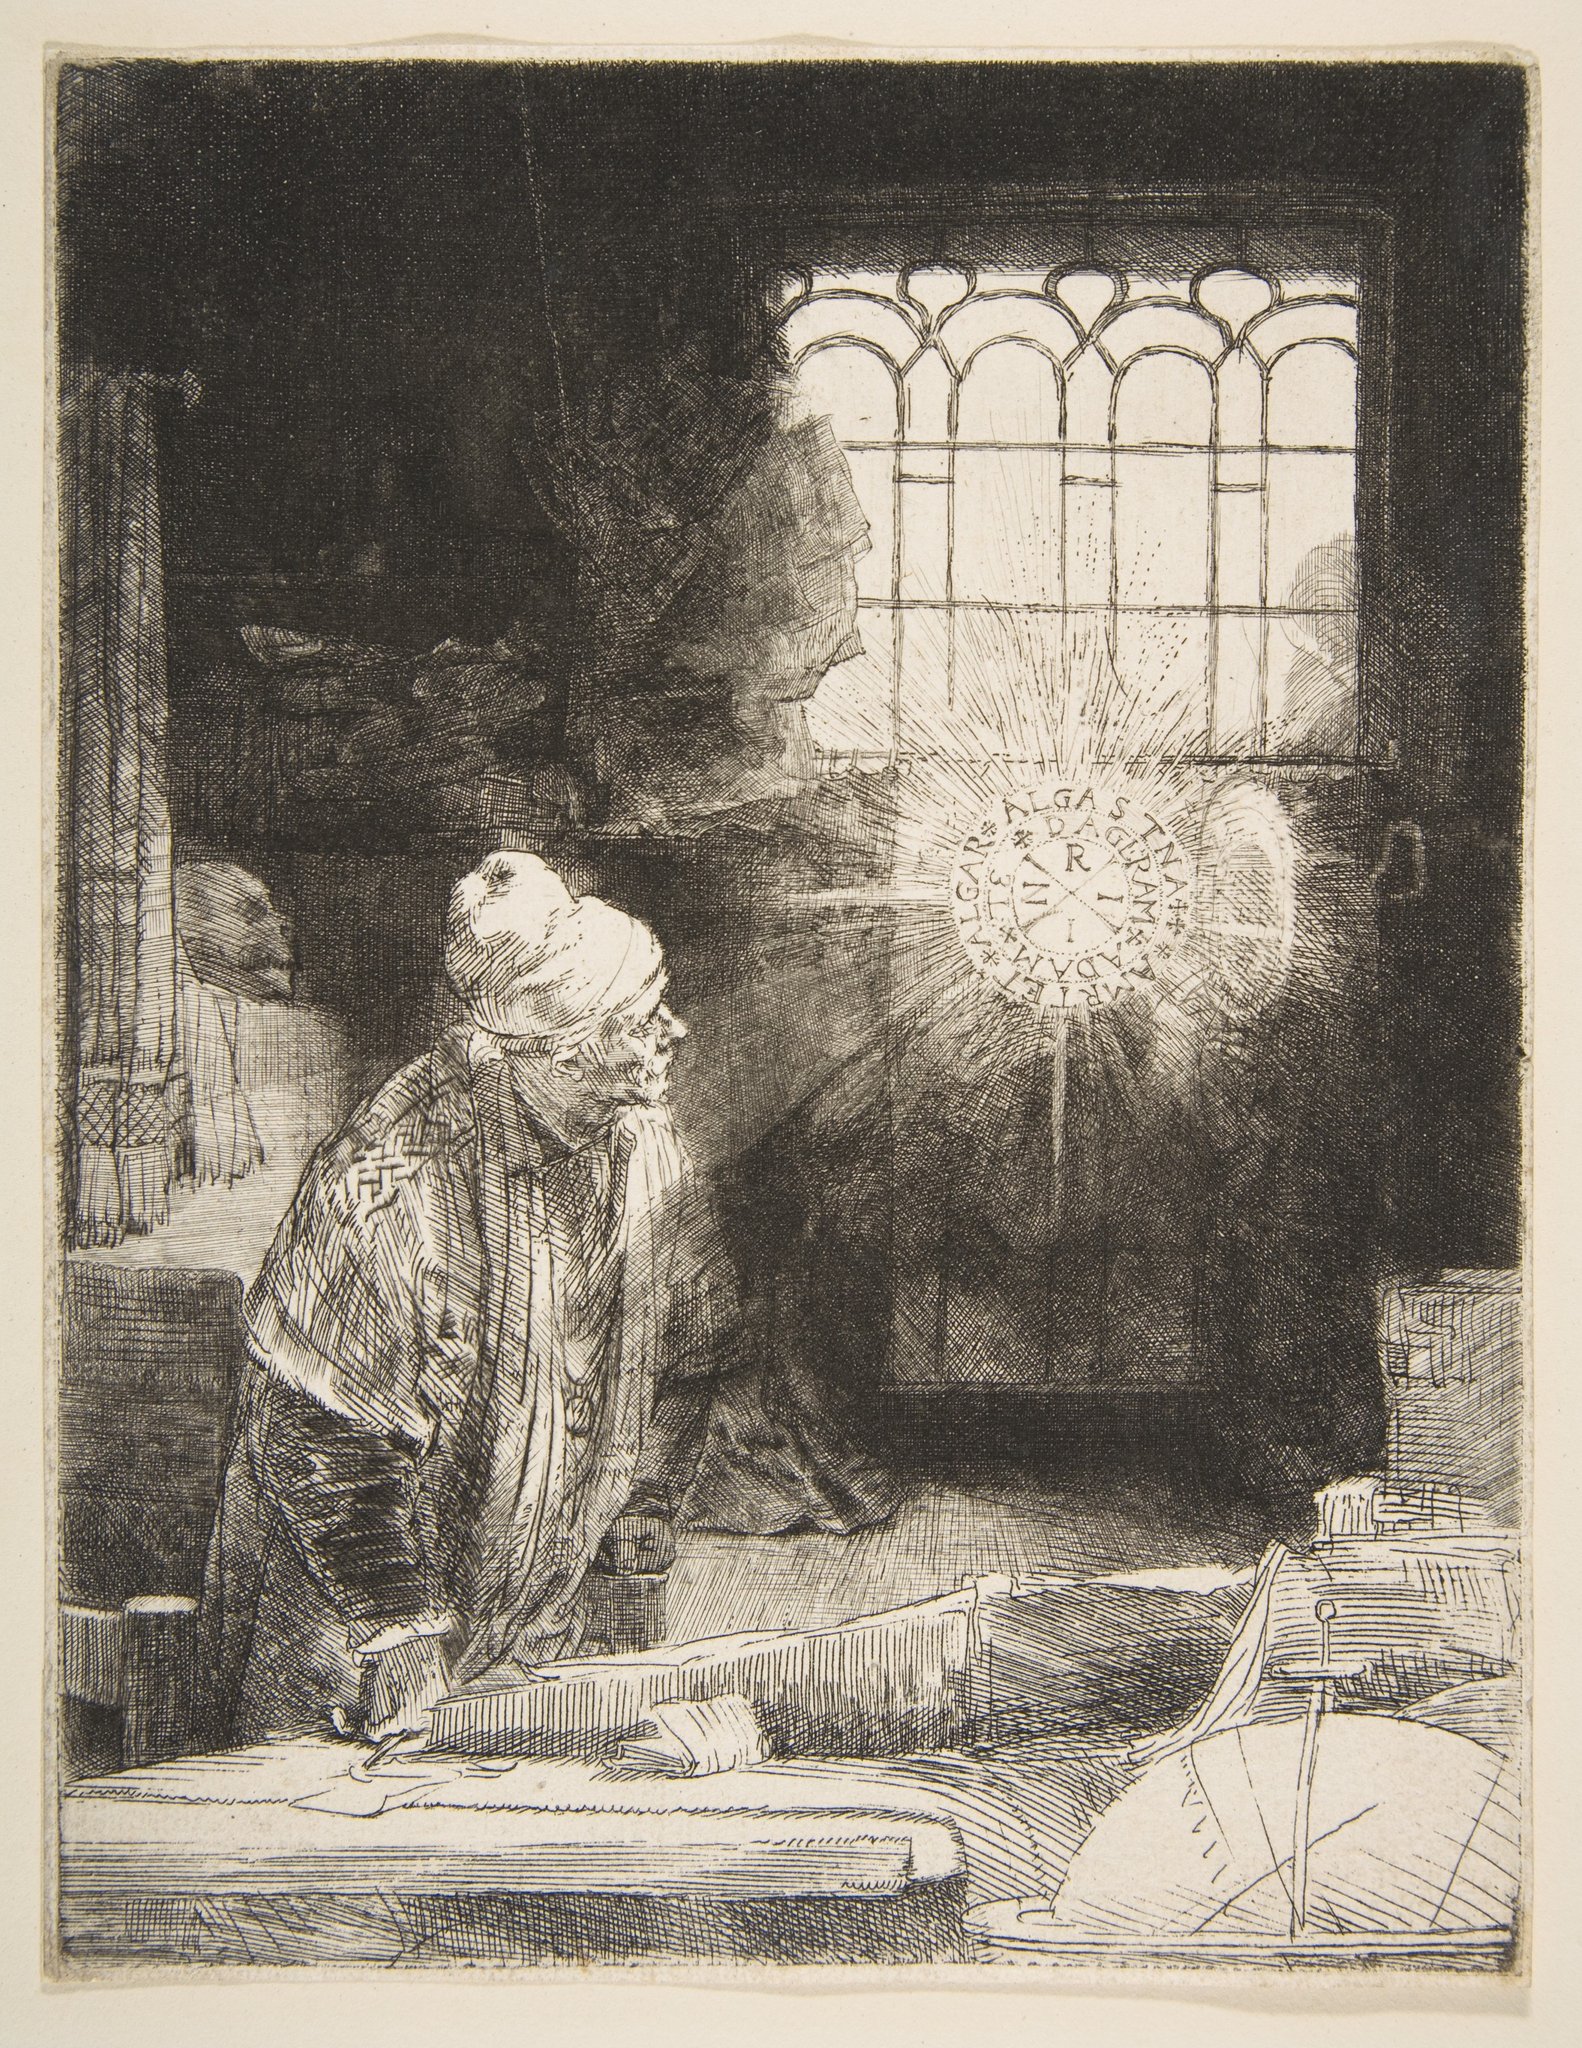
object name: print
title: Faust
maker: rembrandt van rijn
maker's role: artist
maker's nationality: dutch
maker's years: 1606-1669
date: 1652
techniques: drypoint, engraving, etching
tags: windows,men